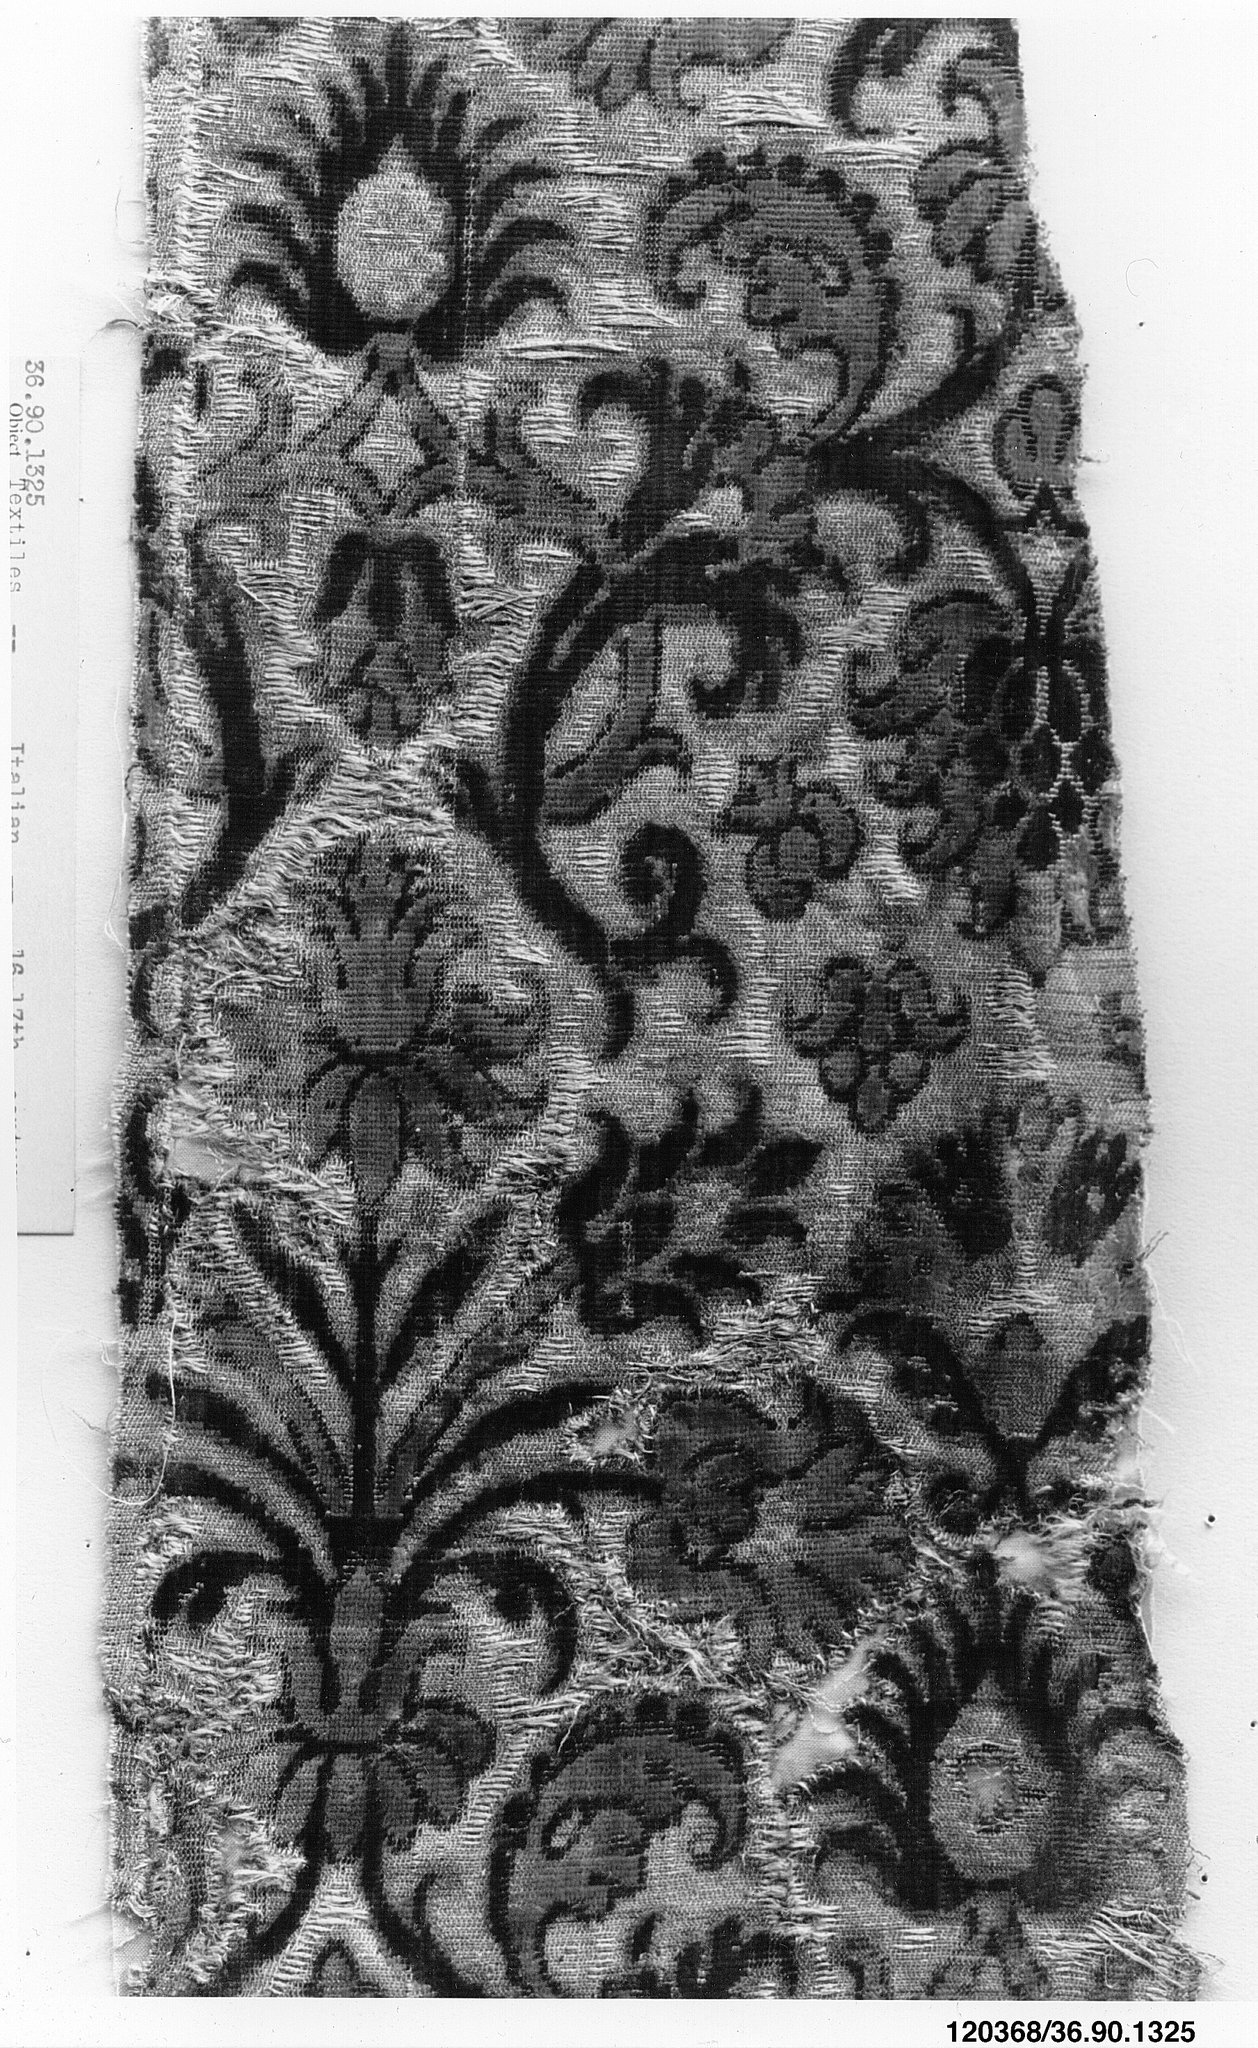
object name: piece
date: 1501-1700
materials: metal thread, silk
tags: flowers,leaves